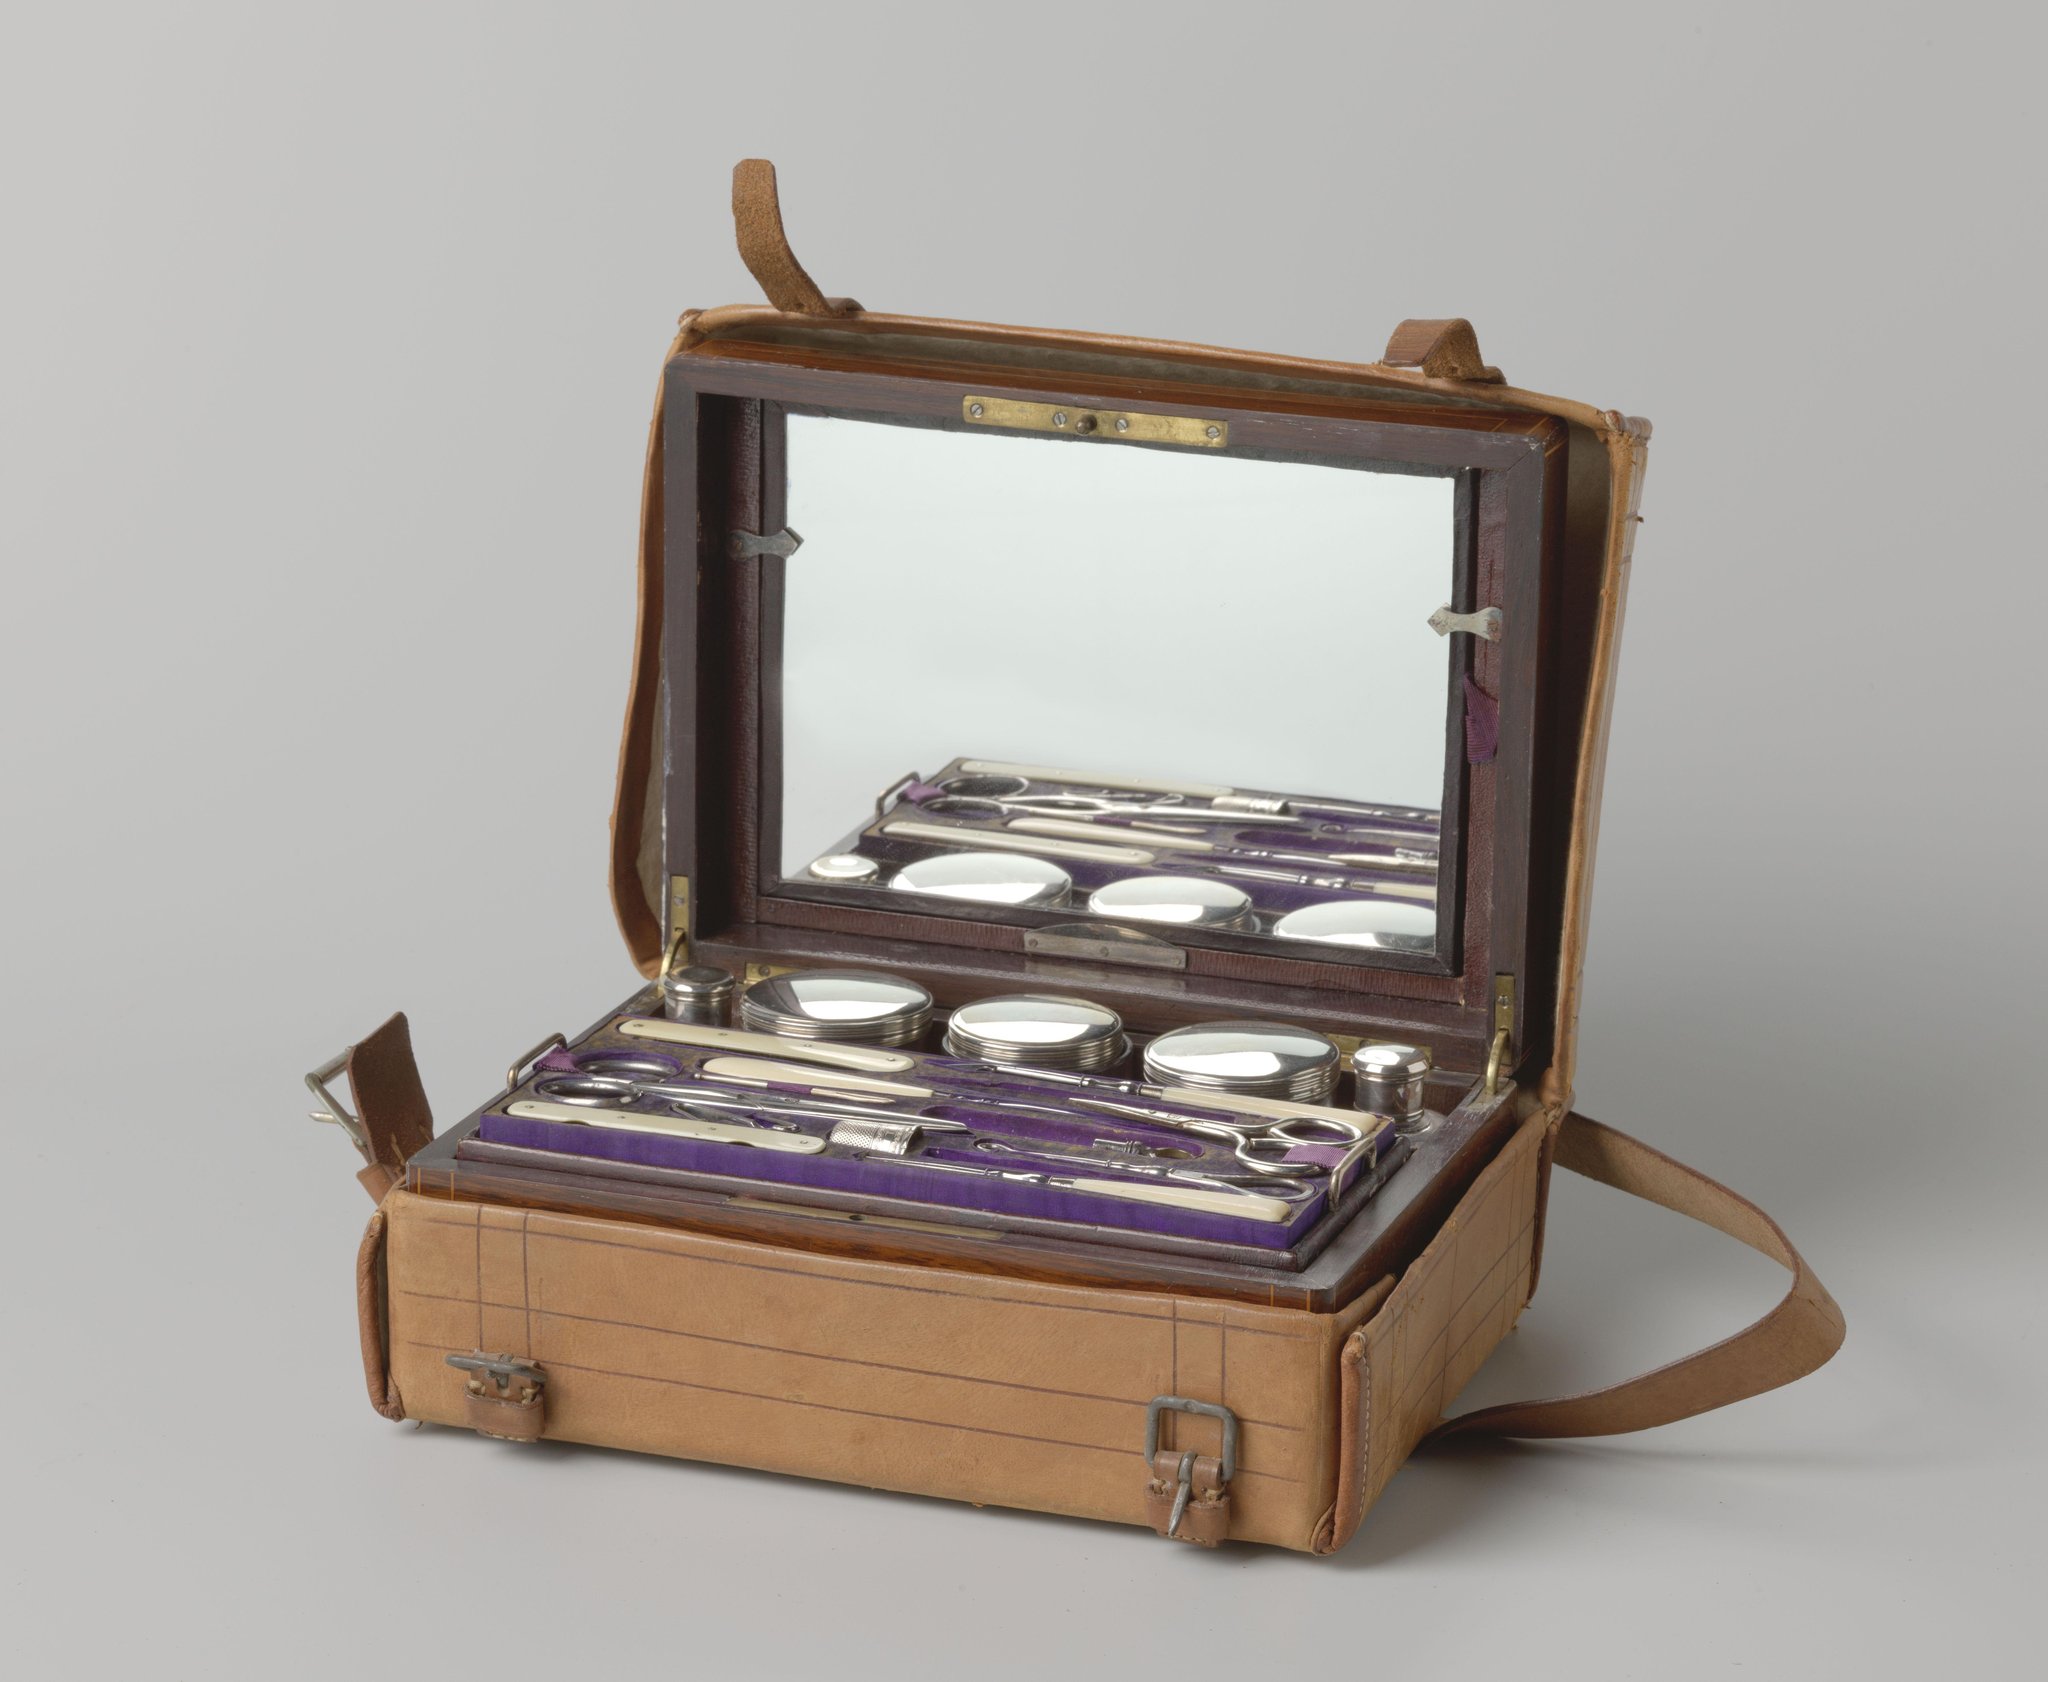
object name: reisnecessaire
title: Reisnecessaire in foedraal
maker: Anonymous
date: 1819-1838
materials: bone, glass, leather, wood, silver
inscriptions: maker's mark: ‘J.C.’, assayer's mark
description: In de deksel zit een spiegel. Daarvoor een lederen schrijfmap. De voering van de kist is van rood leer. Het slot heeft een sleutel. Om de kist zit een leren foedraal. Inhoud: twee rechthoekige flacons met zilveren schroefdoppen en stoppen, twee ronde flacons met zilveren deksels, een kleine flacon met zilveren deksel met lederen houder, een glas, een kledingborstel, een haarborstel, twee langwerpige flacons, een nagelborsteltje gemerkt Racine Rue du Bac 42, kam, (tandenborstel en nagelborstel), gemerkt Aucoc Aine. tableau: zakmesje, scheermesje, priem, twee nagelgarnituren (alle met benen heften), schaar gemerkt Aucoc, zilveren vingerhoed, zilveren stopnaald, servethaak, schoenenhaak.